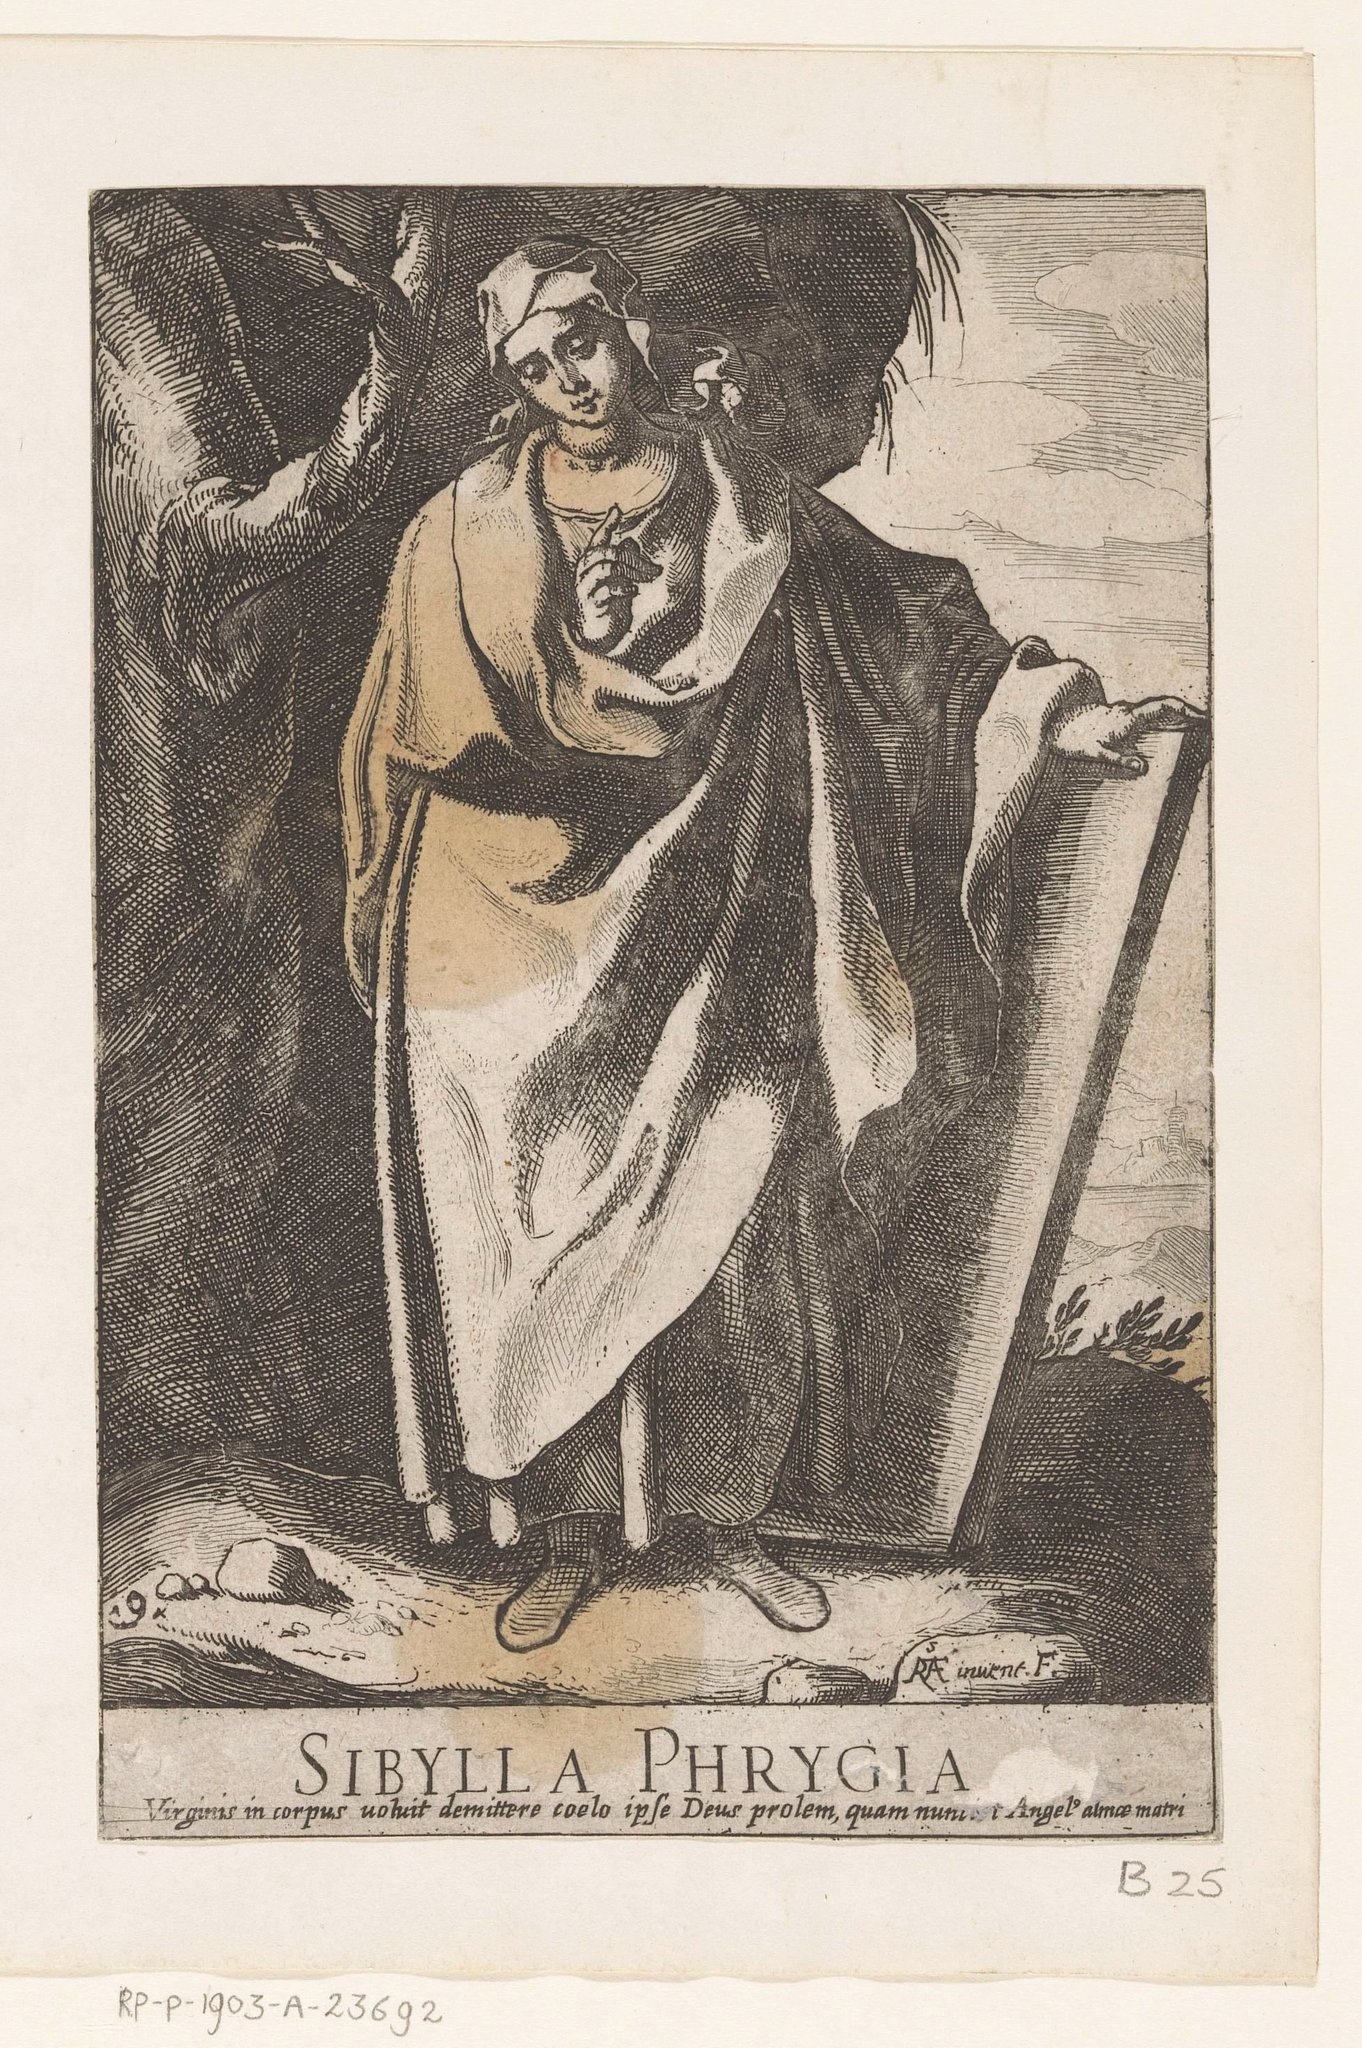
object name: print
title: Sibillaru decem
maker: raffaello schiaminossi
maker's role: painter, print maker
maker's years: 1572-1622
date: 1606-1609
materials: paper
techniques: etching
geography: italy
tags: writing tablets, sibyls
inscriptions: collector's mark: Lugt 2228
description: Deze prent maakt deel uit van een serie bestaande uit een titelprent en tien prenten met voorstellingen van Sibillen. De serie is driemaal uitgegeven: eenmaal in 1606 en tweemaal in 1609 (door Nicolaus van Aelst en door Giovanni Orlandi). Om deze reden worden de prenten uit deze serie hier 1606-1609 gedateerd, behalve indien de individuele prent zelf gedateerd is.